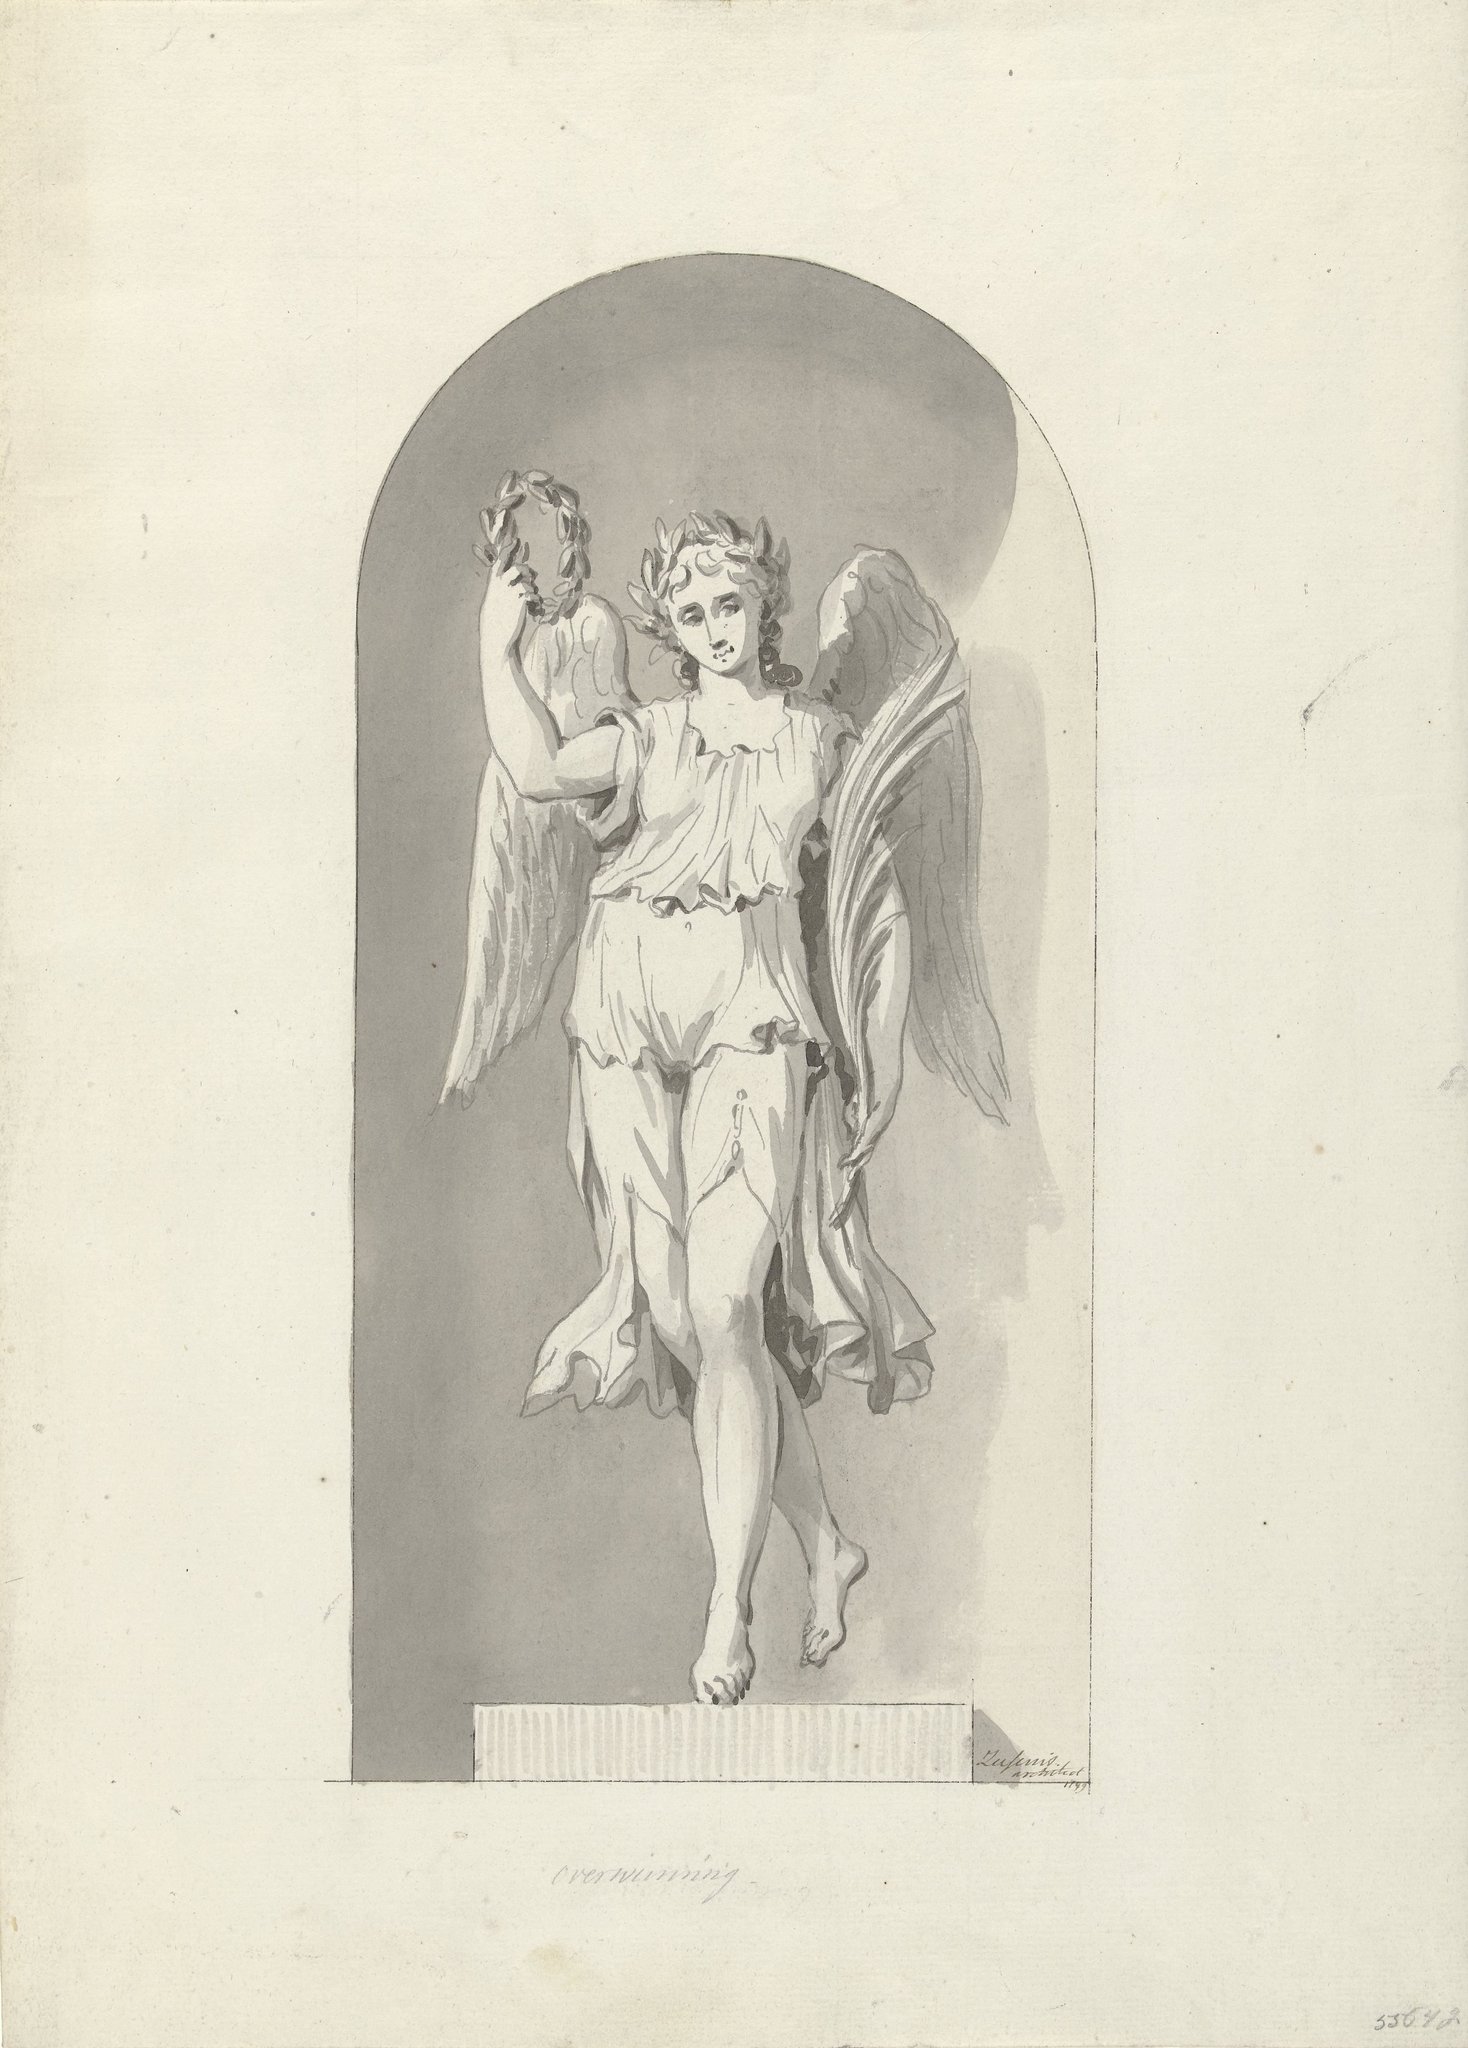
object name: design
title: Ontwerpen voor het monument op het nationale feest ter viering van de vrede van 17 december 1799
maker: bartholomeus ziesenis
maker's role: draughtsman, sculptor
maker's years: 1768-1820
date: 1799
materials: ink, paper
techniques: brush, pen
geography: netherlands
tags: 'victoria'; 'vittoria', 'vittoria navale', 'vittoria degl'antichi' (ripa), monument, statue, peace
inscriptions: inscription: ‘Ziesenis architect 1799’